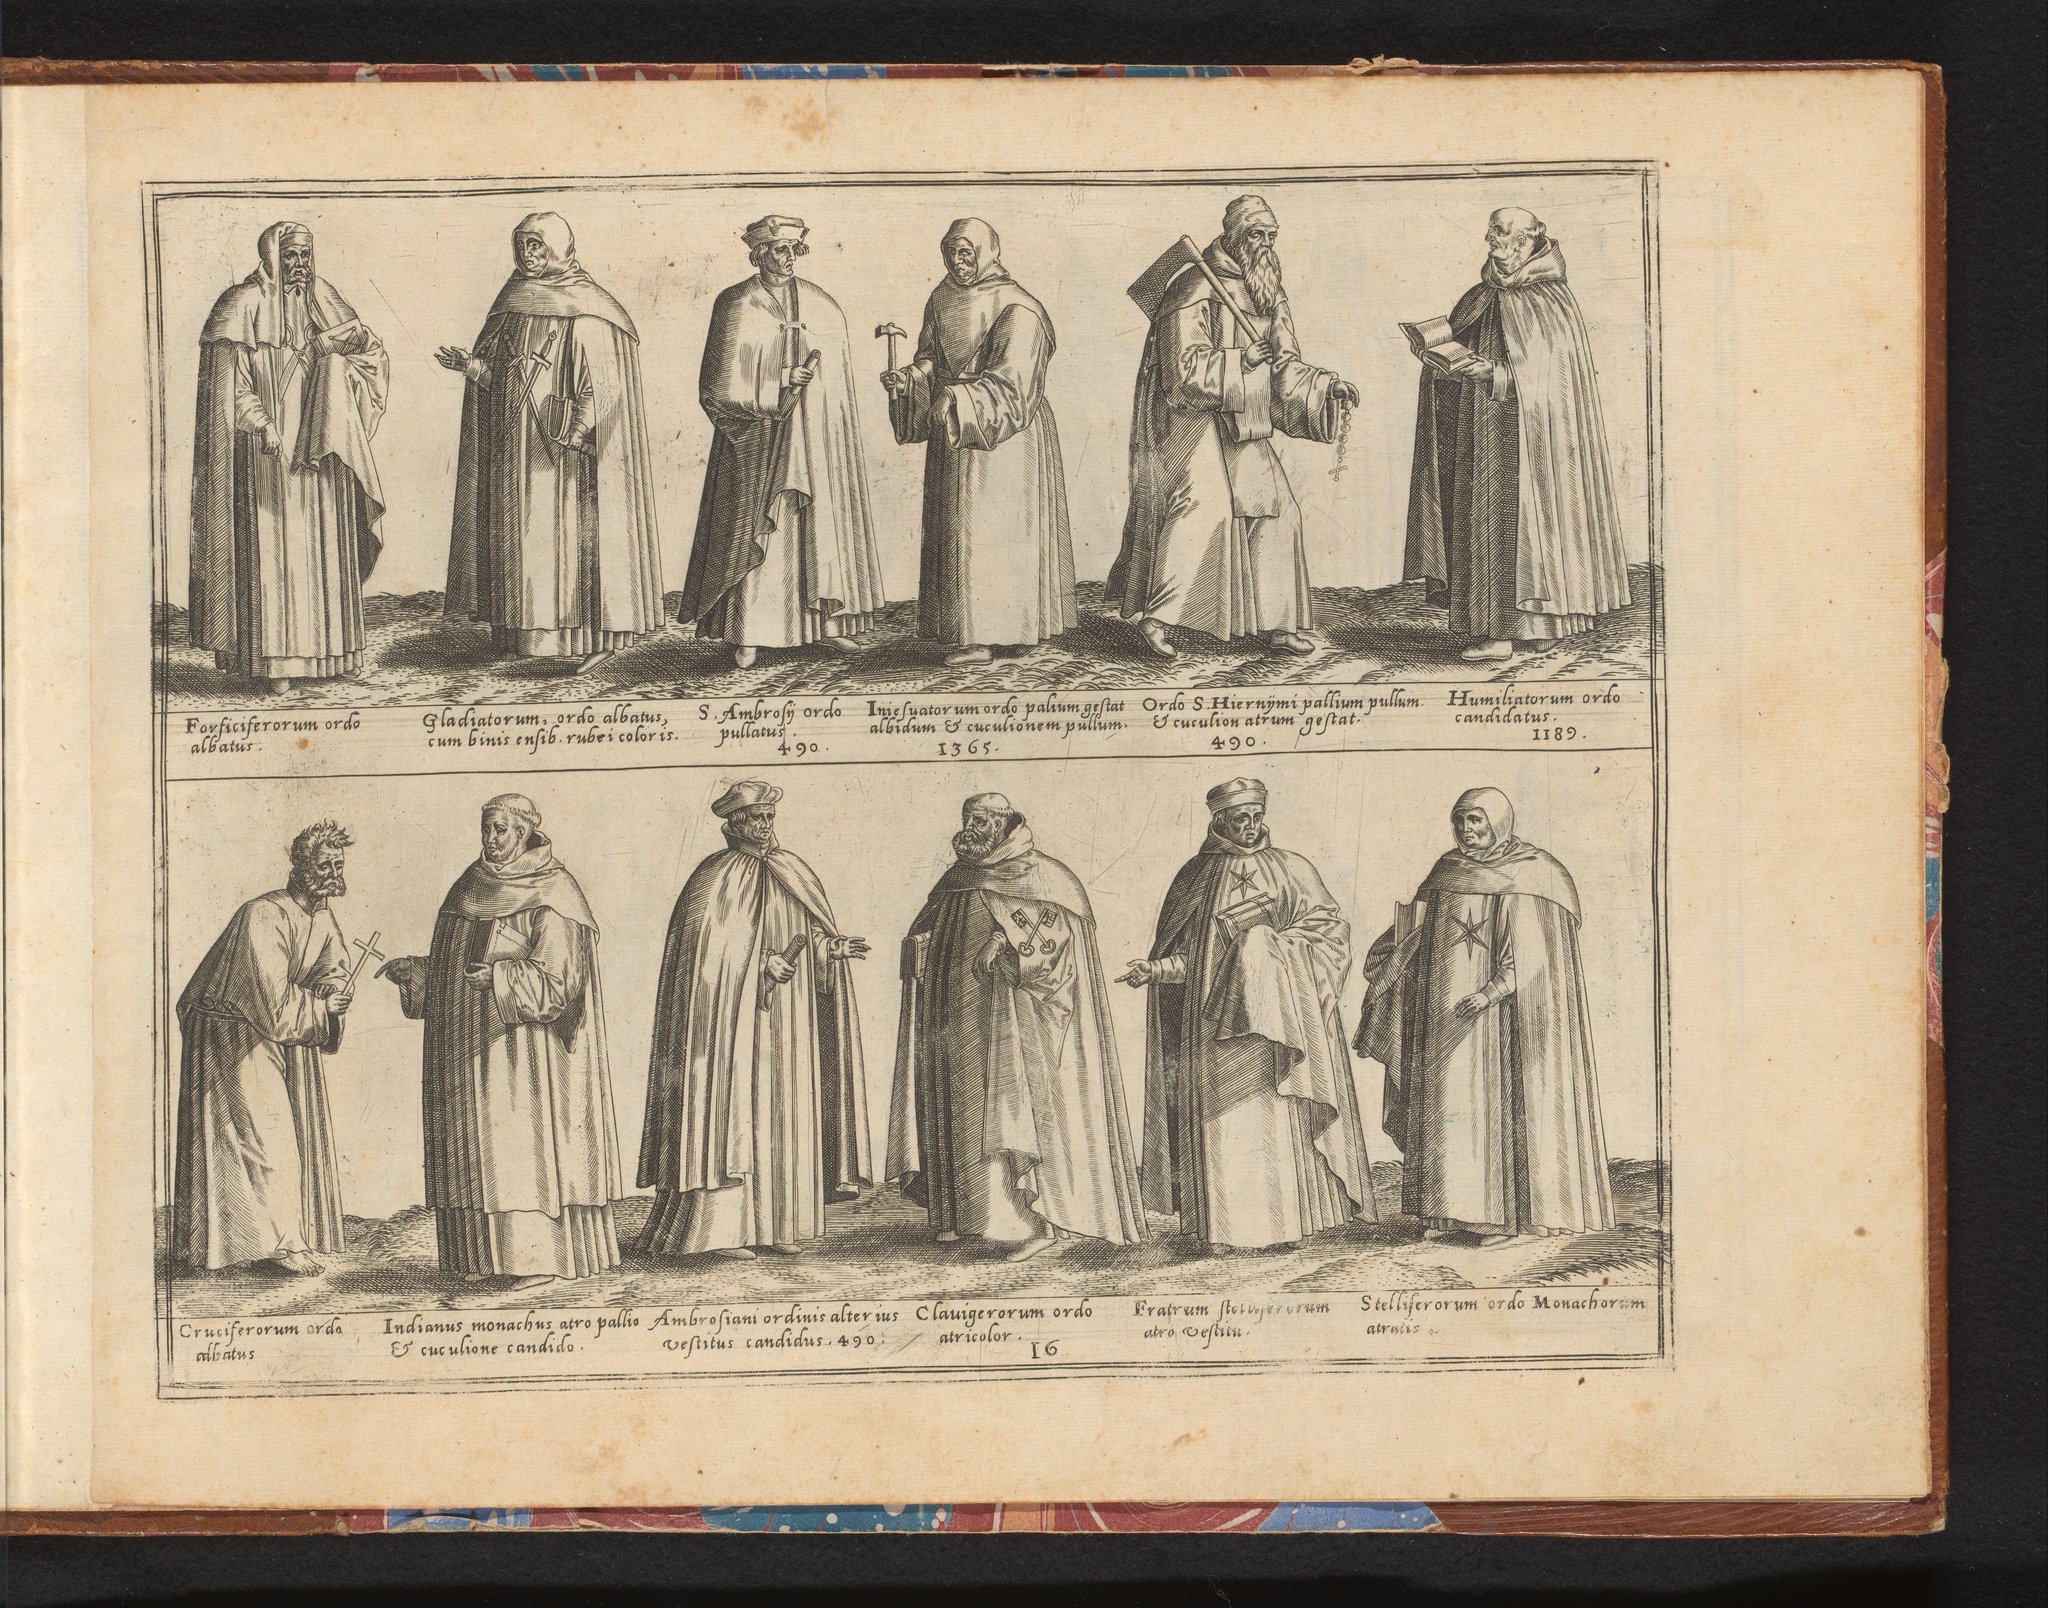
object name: costume print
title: Twaalf monniken en kluizenaars uit verschillende orden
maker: abraham de bruyn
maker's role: print maker, publisher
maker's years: 1540-1587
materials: paper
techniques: engraving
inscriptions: number: ‘16’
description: In twee rijen boven elkaar. Prent uit het boek 'Omnium pene Europae, Asiae, Aphricae atque Americae gentium habitus...', 1581. De prent maakt deel uit van een album.